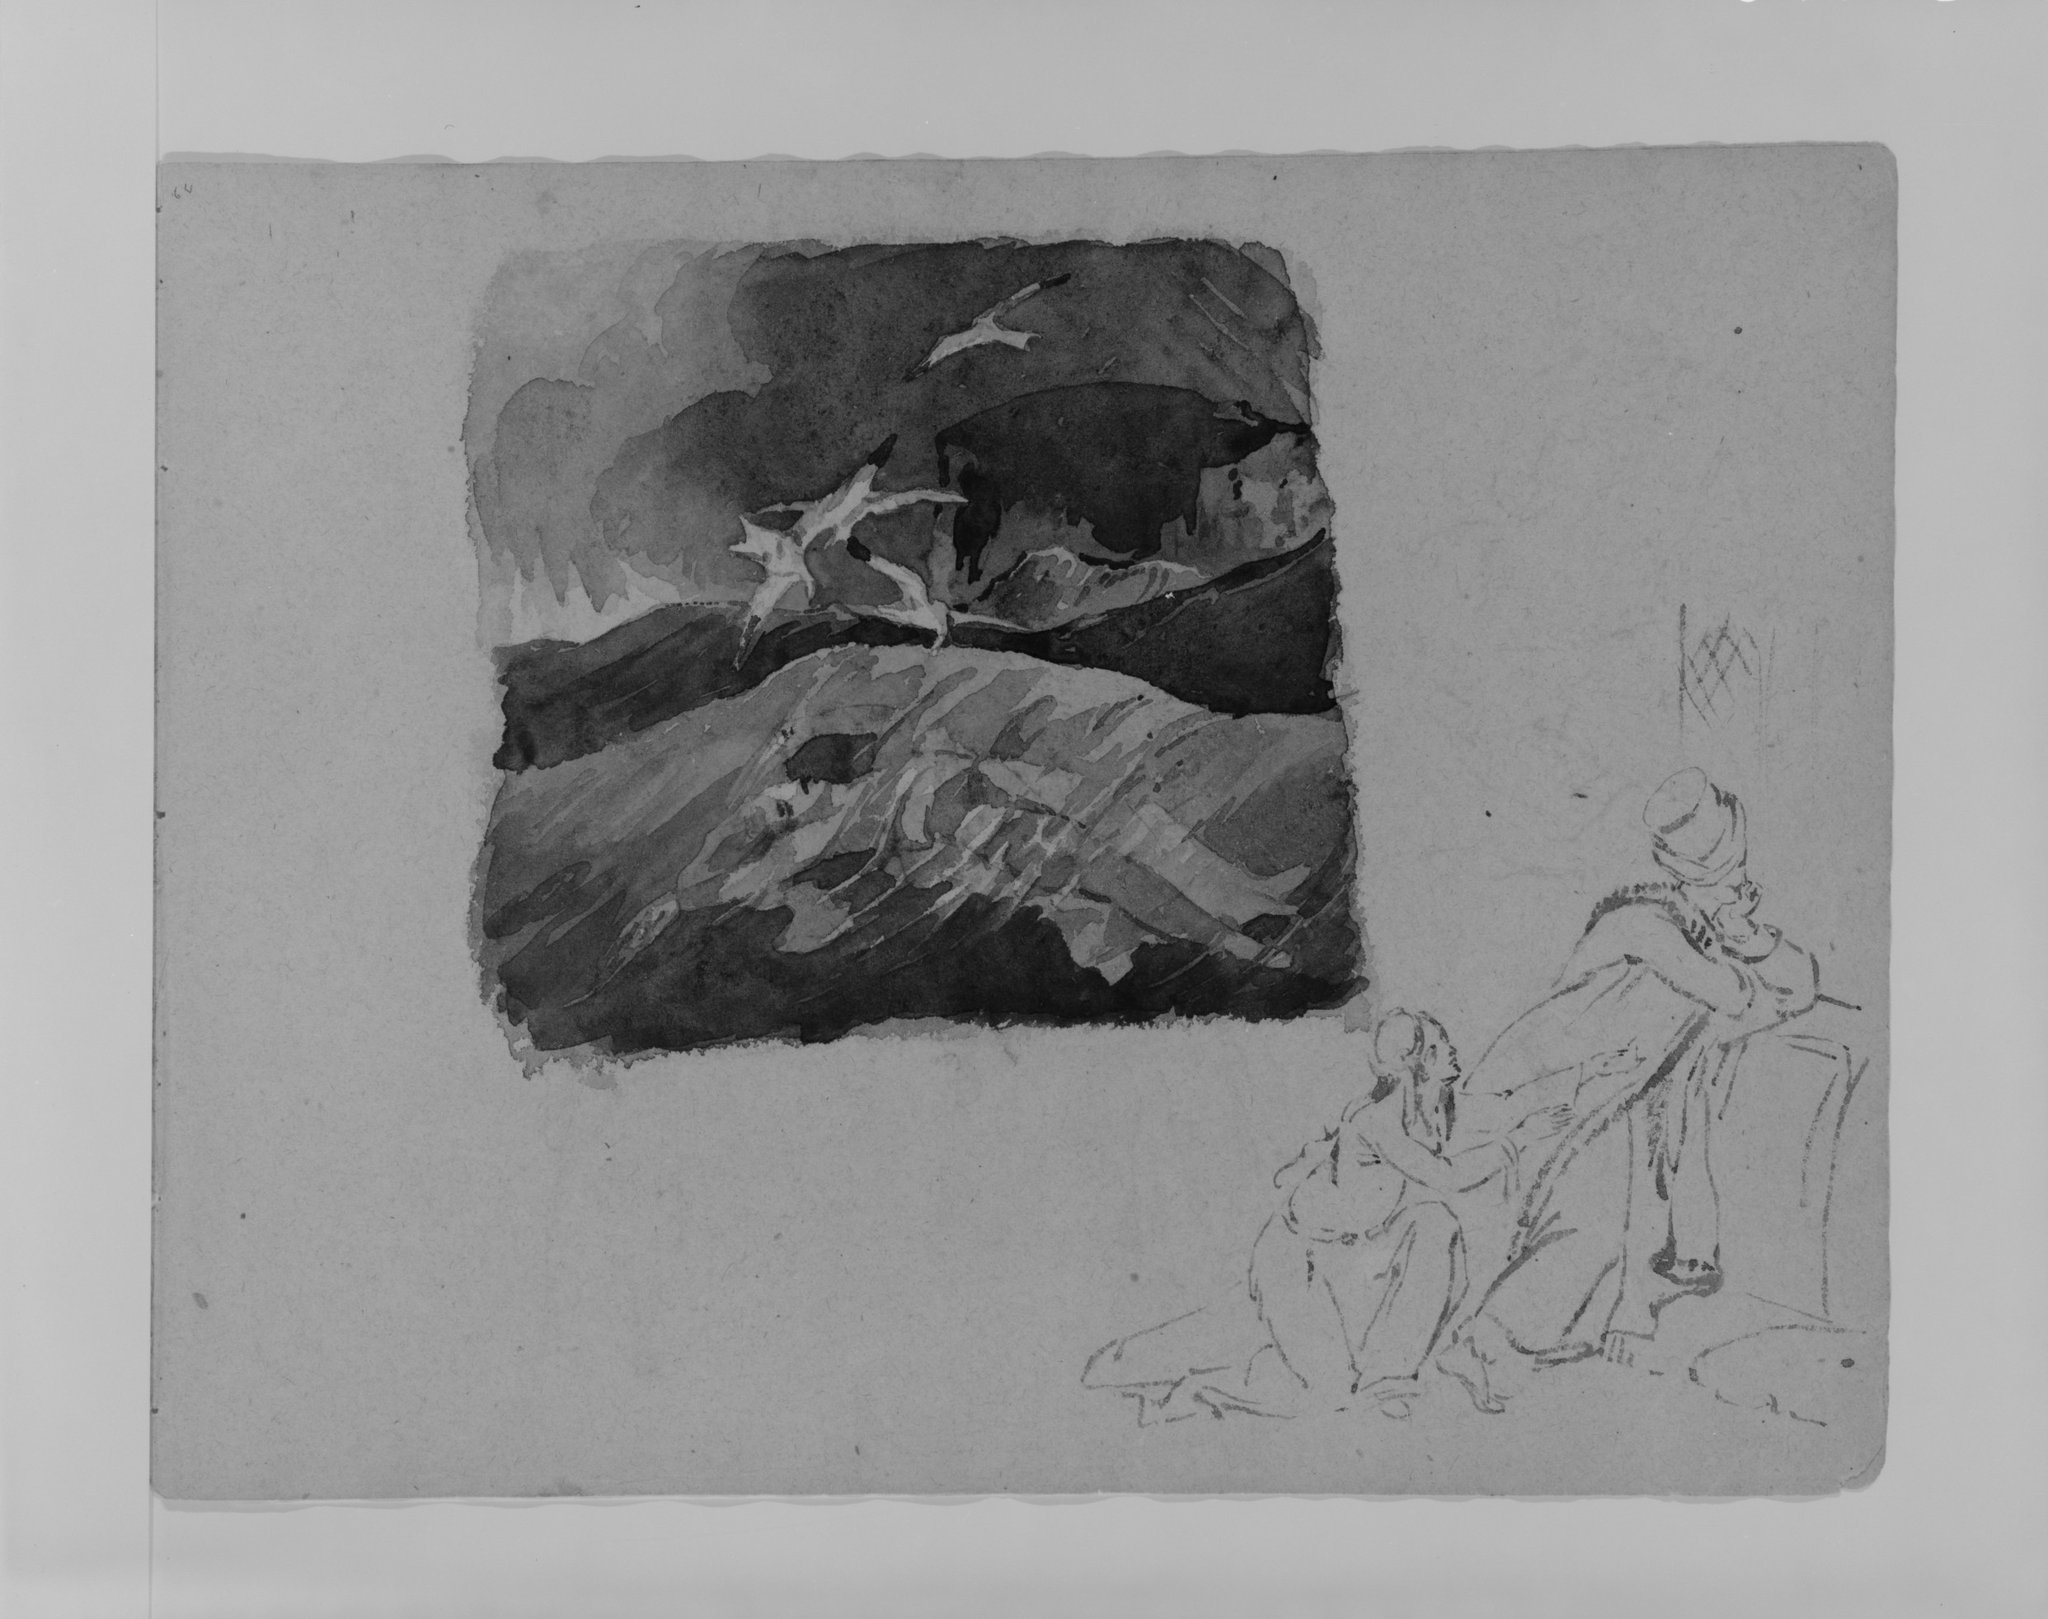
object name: drawing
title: Drowned Man in Sea; Two Figures in Turkish Costume (from Sketchbook)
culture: american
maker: thomas sully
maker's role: artist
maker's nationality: american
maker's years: 1783-1872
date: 1810-1820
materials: ink, paper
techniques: wash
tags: birds,men